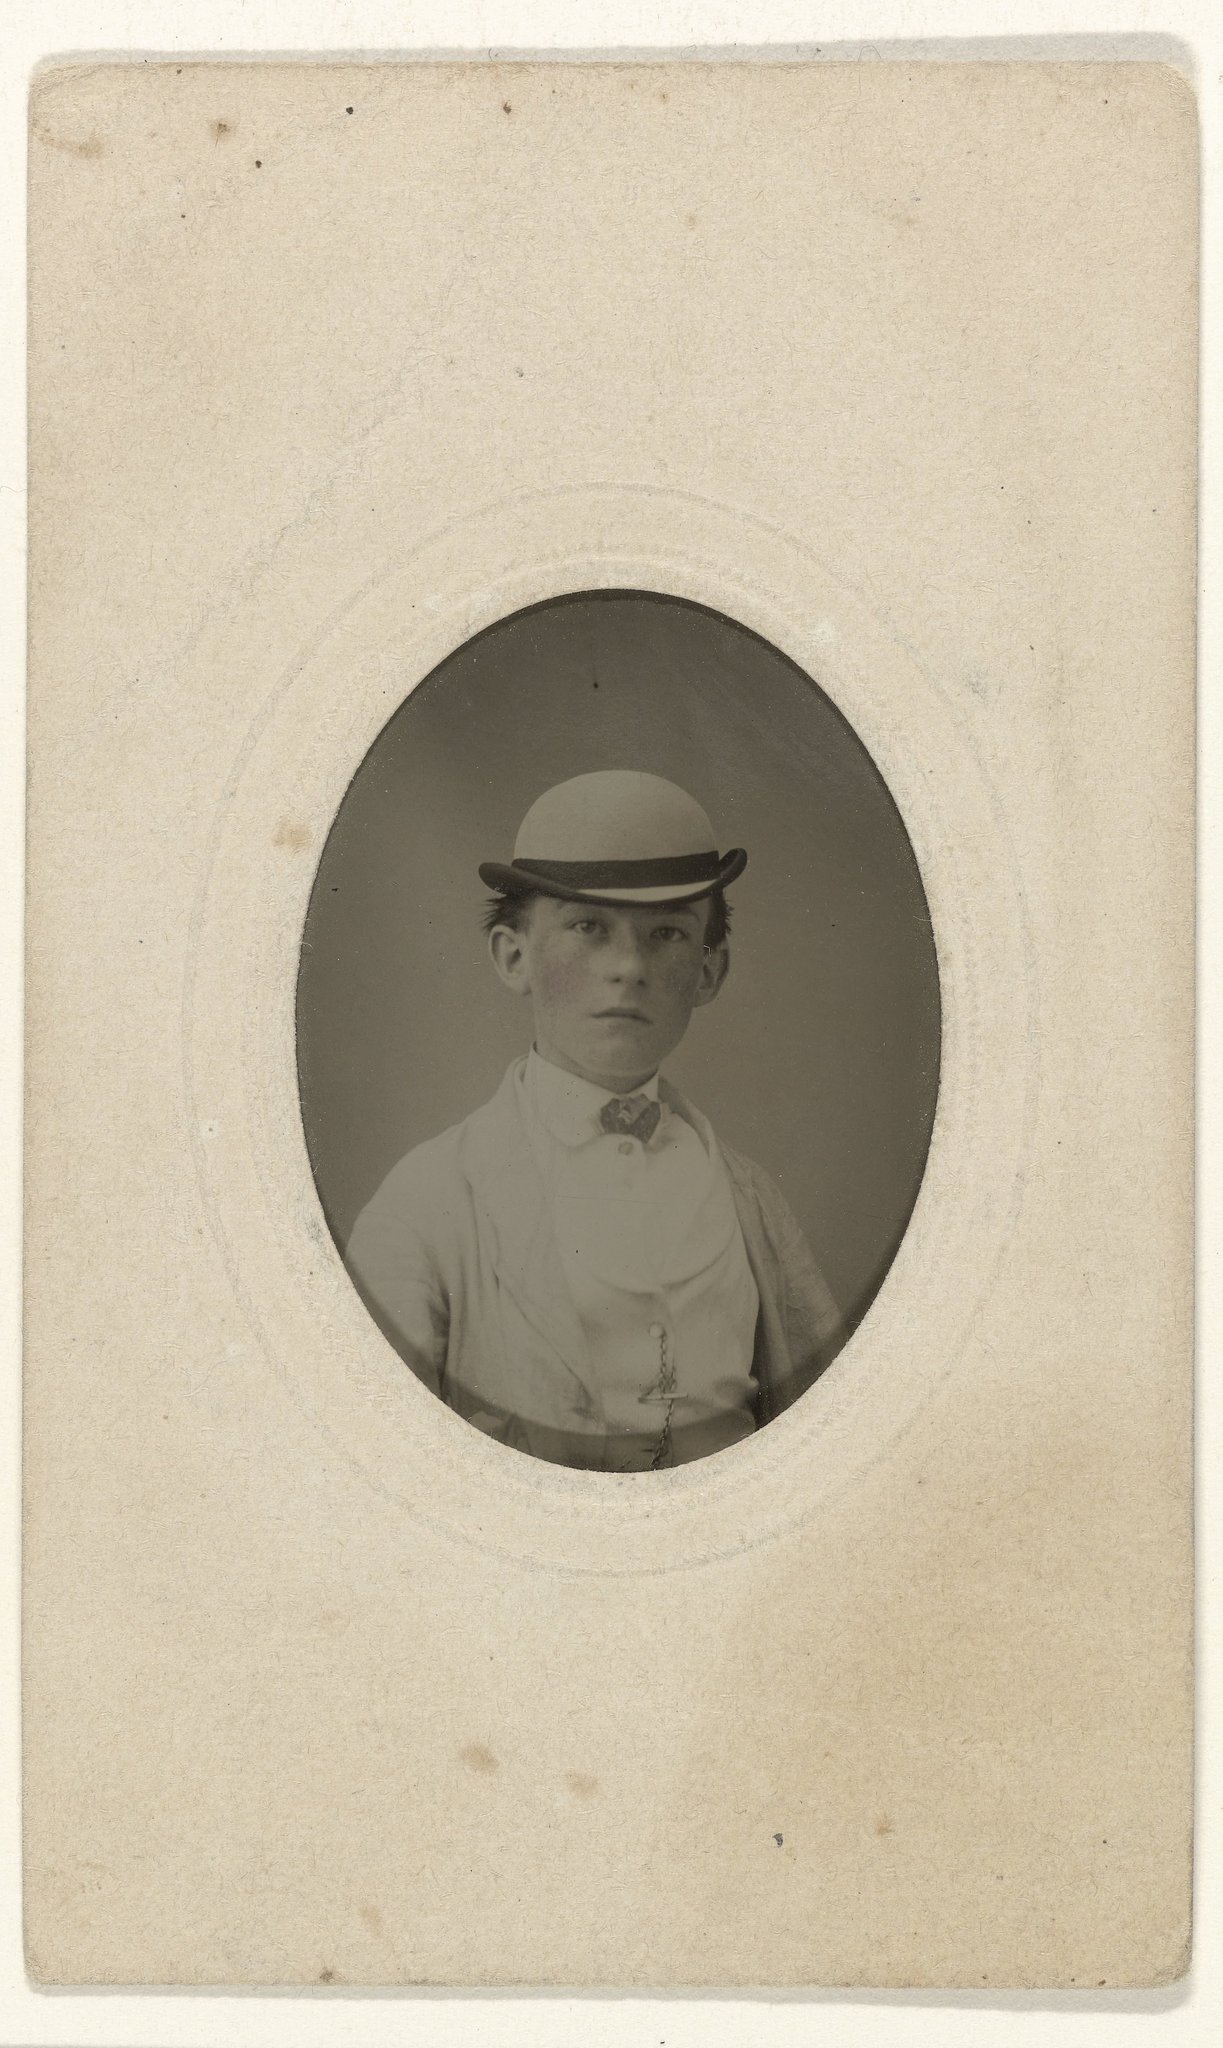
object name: photograph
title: Portret van een jongen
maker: fernando dessaur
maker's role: fotograaf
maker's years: 1840-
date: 1870-1900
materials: metal, paper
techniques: ferrotyping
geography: new york city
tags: boy (child between toddler and youth), anonymous historical person portrayed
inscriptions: inscription: ‘FERNANDO DESSAUR'S // Photograph & Ferrotype Gallery, // 145 Eighth Avenue, NEW YORK.’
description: Portret van een jongen in een papieren passe-partout.